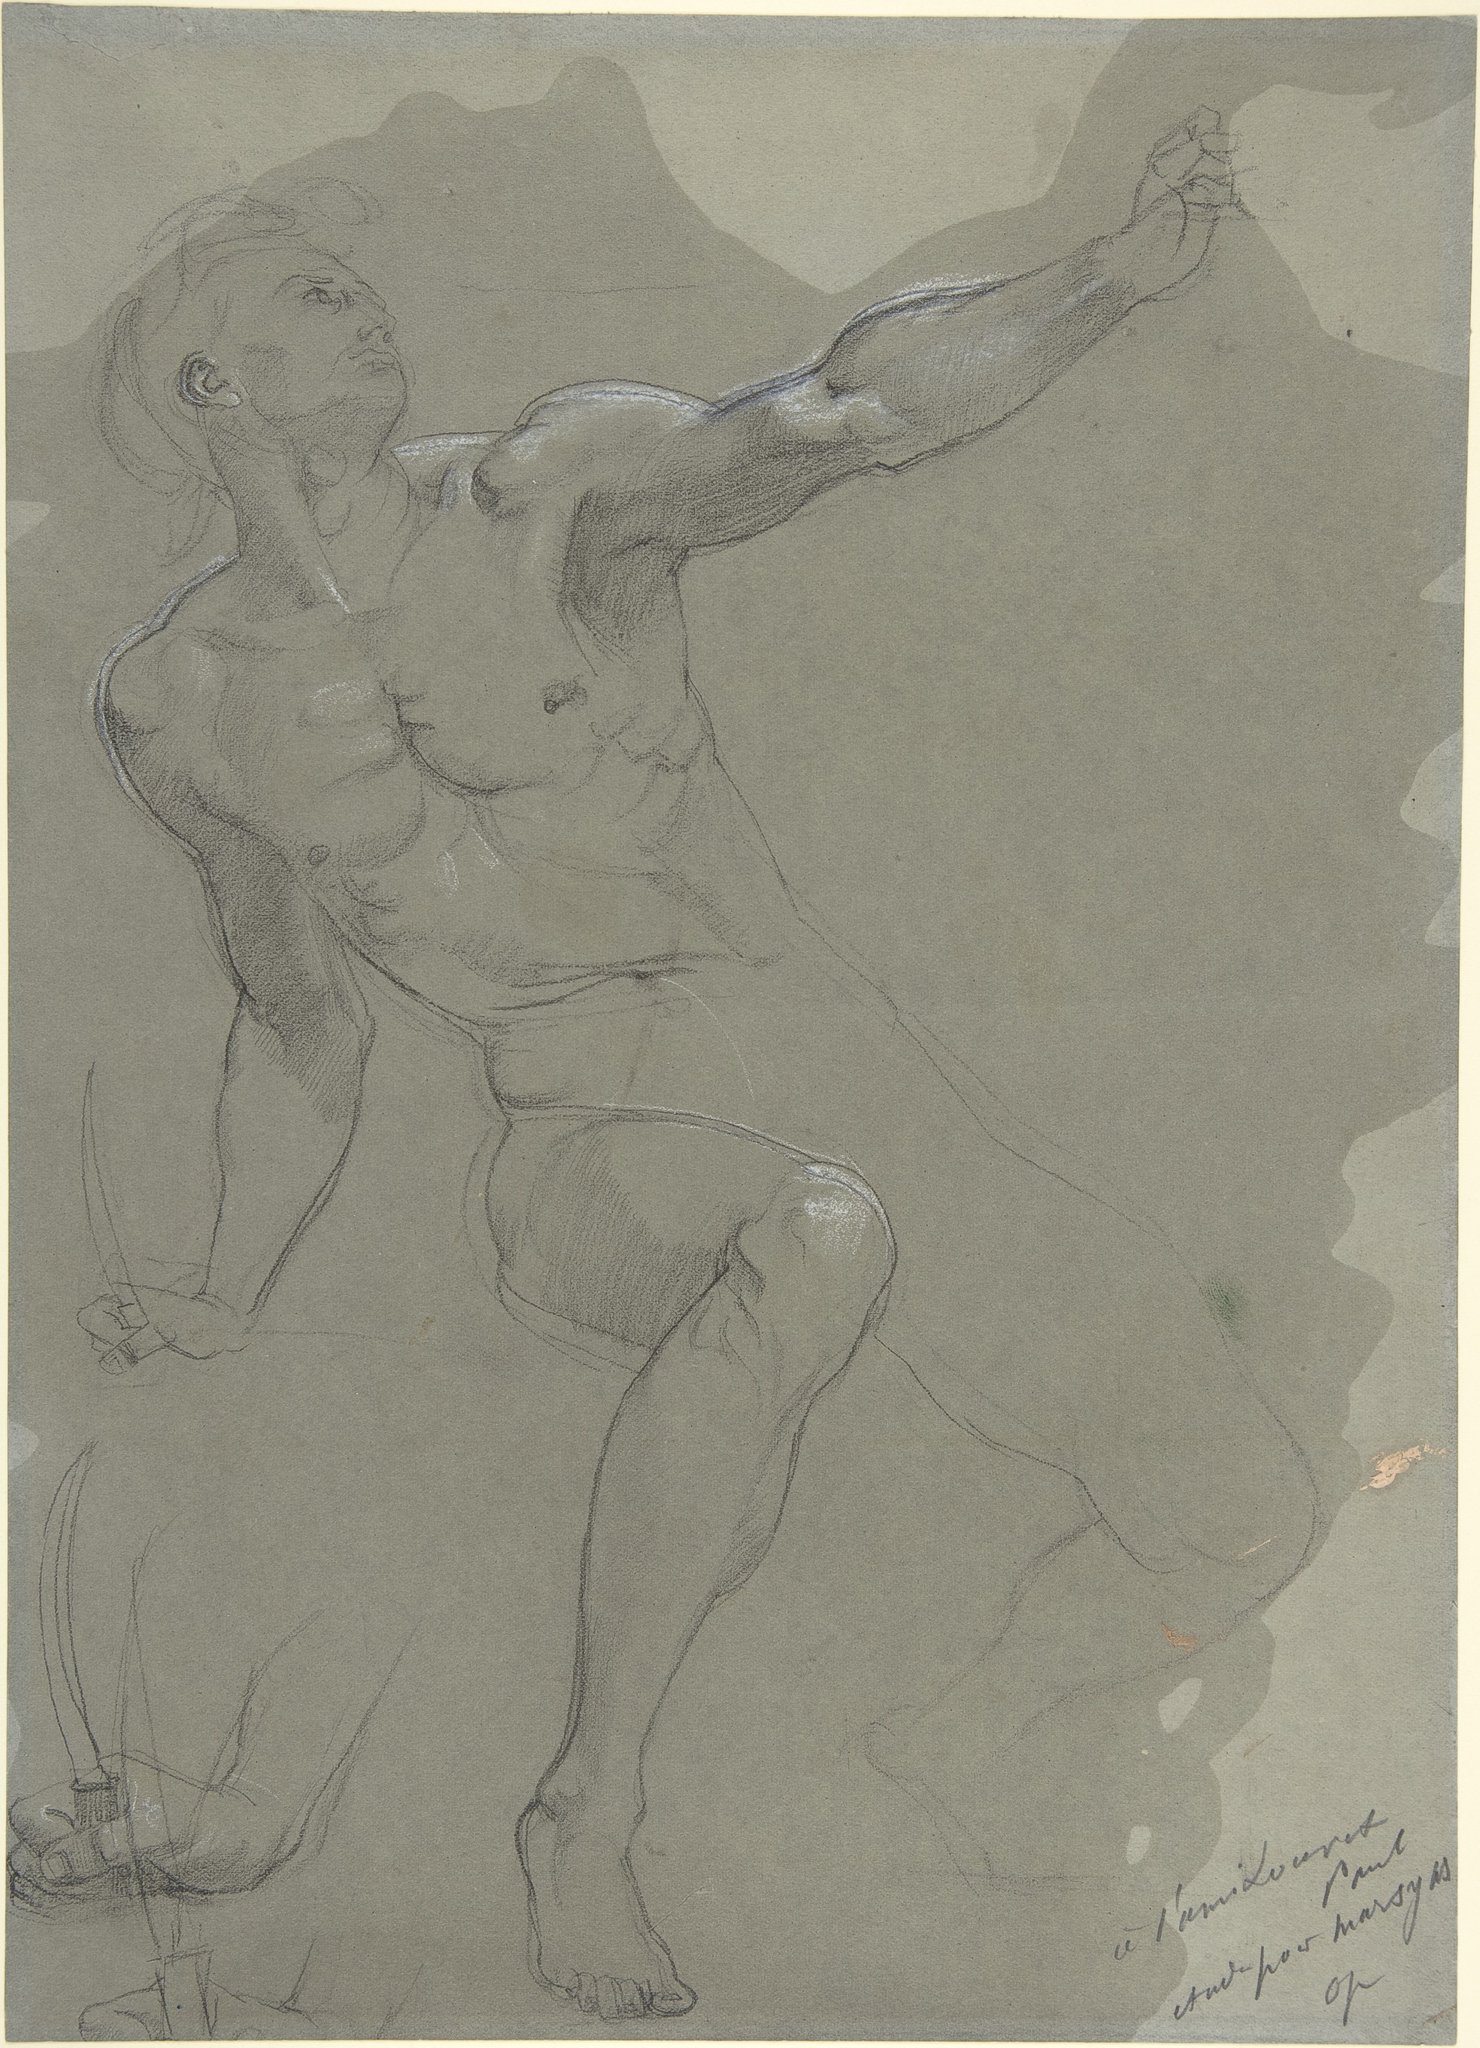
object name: drawing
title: Seated Male Nude (recto); Crouching Male Nude (verso)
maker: paul baudry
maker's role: artist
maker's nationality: french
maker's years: 1828-1886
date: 1864-1874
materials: chalk, paper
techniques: heightening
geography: france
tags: male nudes